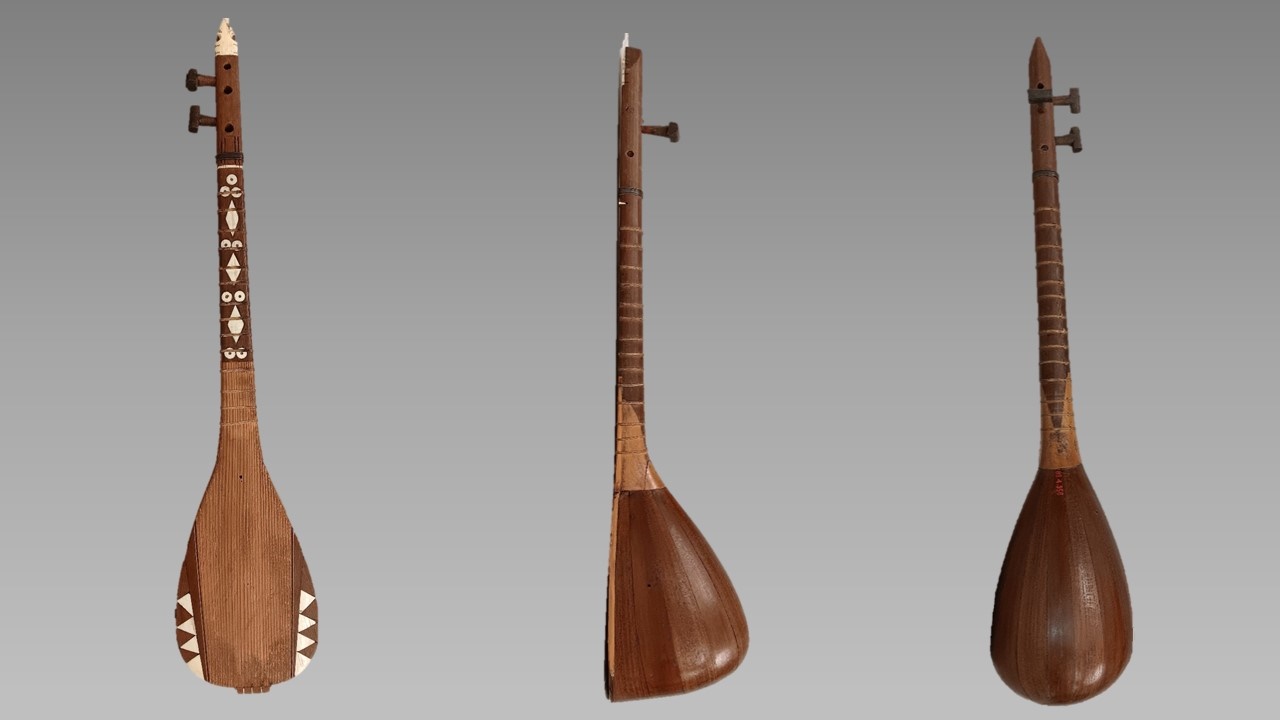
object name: saz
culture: syrian or turkish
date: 1867-1900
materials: bone, wood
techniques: inlay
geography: iran